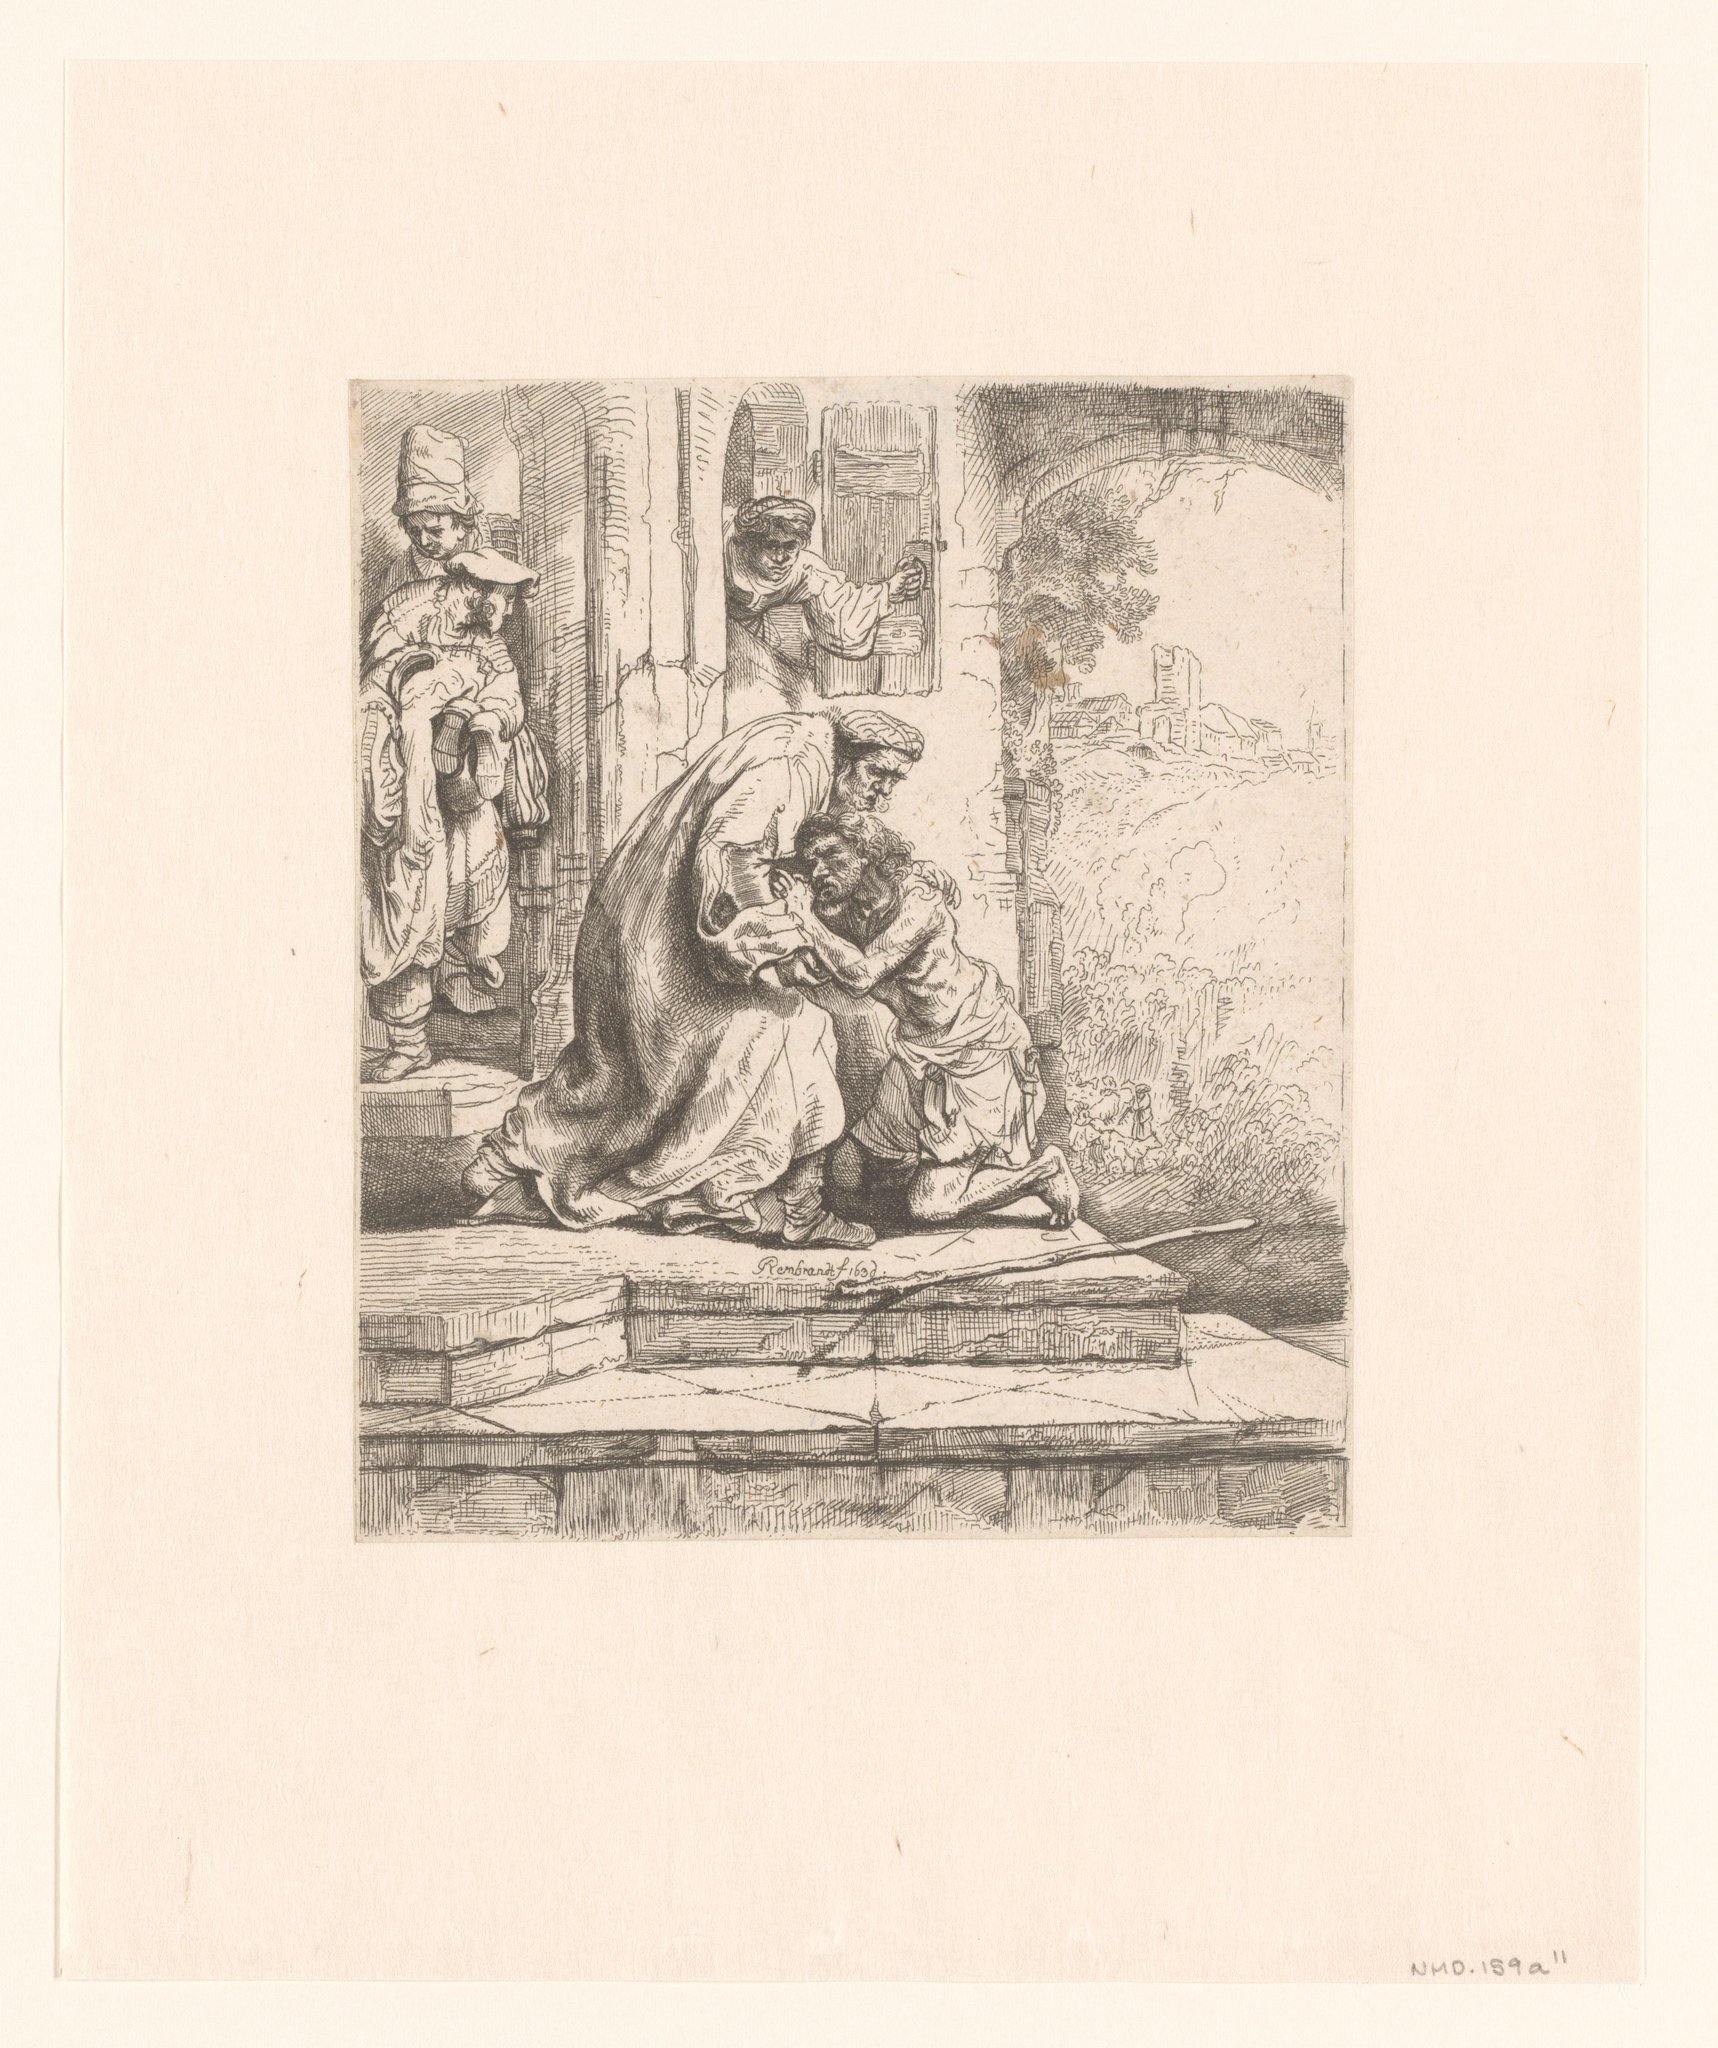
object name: print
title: The return of the prodigal son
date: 1711-1800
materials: paper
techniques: etching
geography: augsburg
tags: the parable of the prodigal son (luke 15:11-32)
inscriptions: collector's mark: Lugt 4071, collector's mark: Lugt 2228, collector's mark: Lugt 2760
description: Spiegelbeeldige kopie naar de gelijknamige prent van Rembrandt.